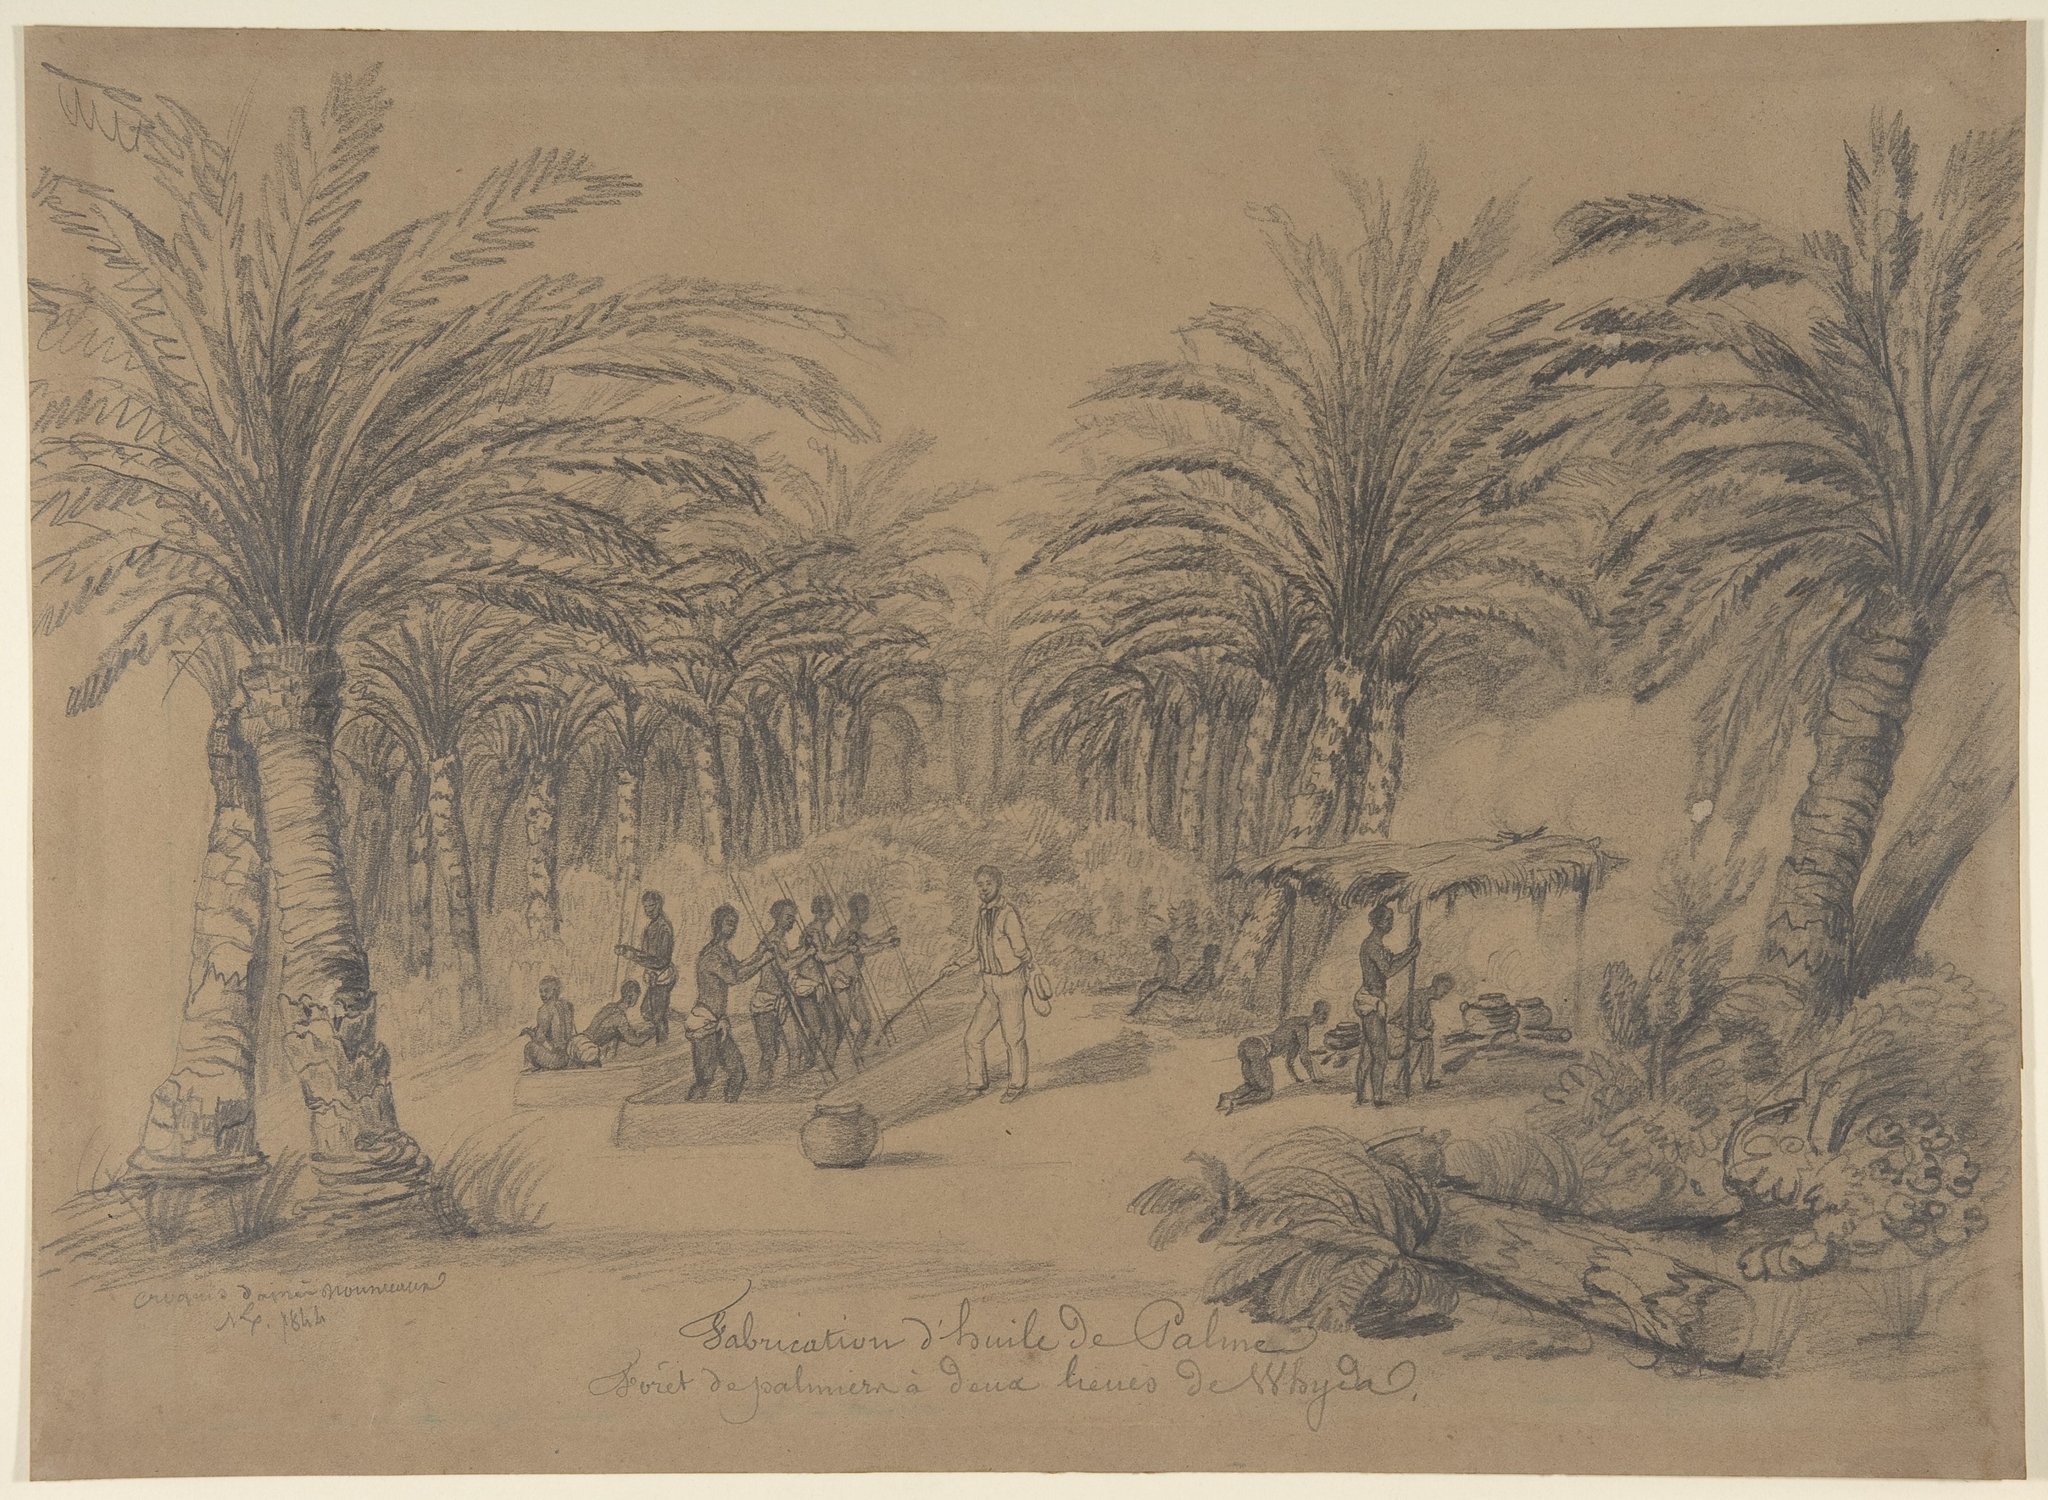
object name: drawing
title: The Production of Palm Oil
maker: anonymous, french, 19th century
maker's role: artist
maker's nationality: french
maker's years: 1800-1900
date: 1844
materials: graphite, paper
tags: men,palms,working